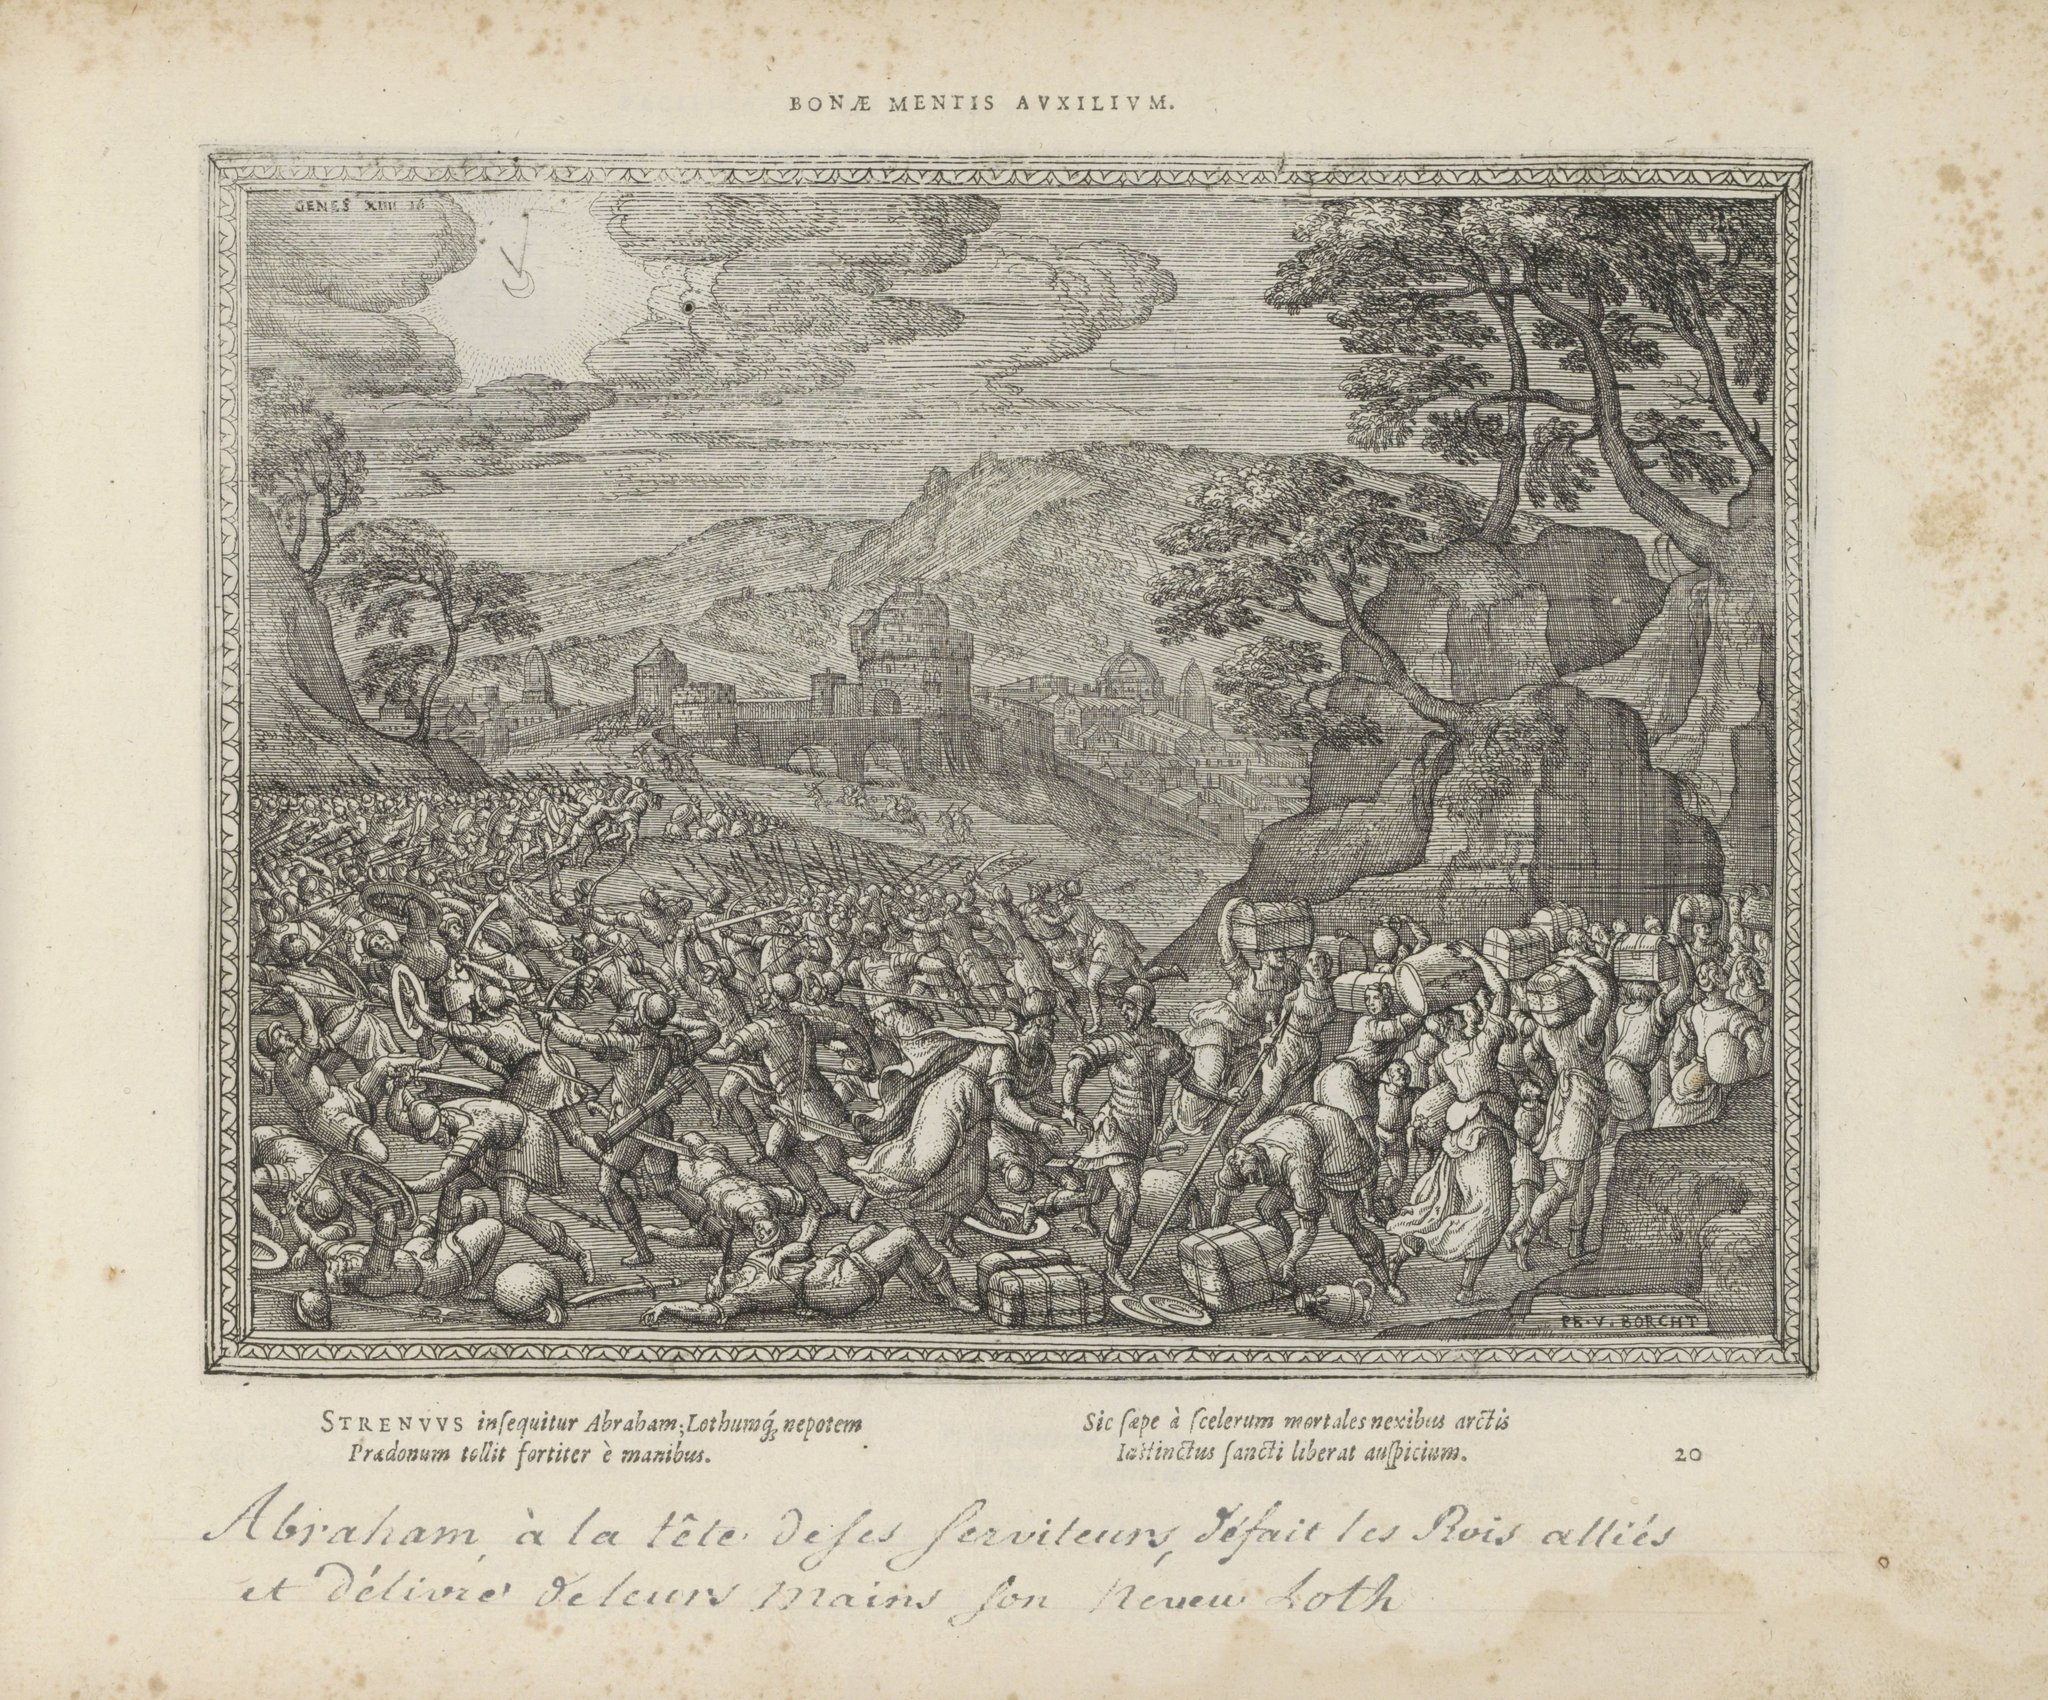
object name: print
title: Imagines et figurae bibliorum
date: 1582-1593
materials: paper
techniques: etching, letterpress printing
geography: amsterdam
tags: the four kings are attacked at night, and defeated by abraham, abraham liberates lot, recovers the stolen goods and returns in triumph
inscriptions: inscription: ‘Abraham à la tete de ses serviteurs défait les Rois alliés et délivre de leurs mains son neveu Loth’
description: Abraham valt 's nachts met zijn mannen het leger van koning Kedorlaomer en diens bondgenoten aan en bevrijdt Lot. Midden onder wordt Lot bij de hand genomen. Rechts worden alle heroverde bezittingen van Lot door de bevrijde vrouwen weggevoerd (Gen. 14:16). Met een motto in het Latijn boven de voorstelling en een vierregelig onderschrift in het Latijn onder de prent. De prent maakt deel uit van een album.